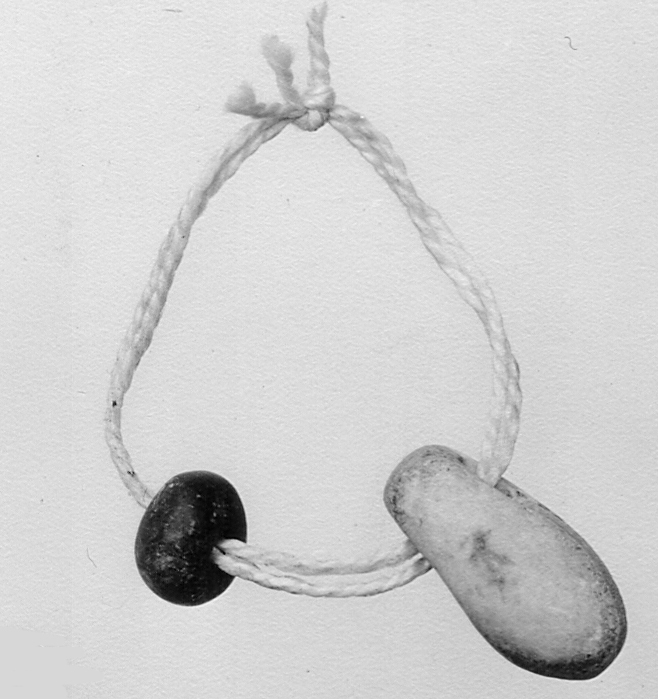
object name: anklet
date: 4400-3800 BCE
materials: bone, stone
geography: egypt